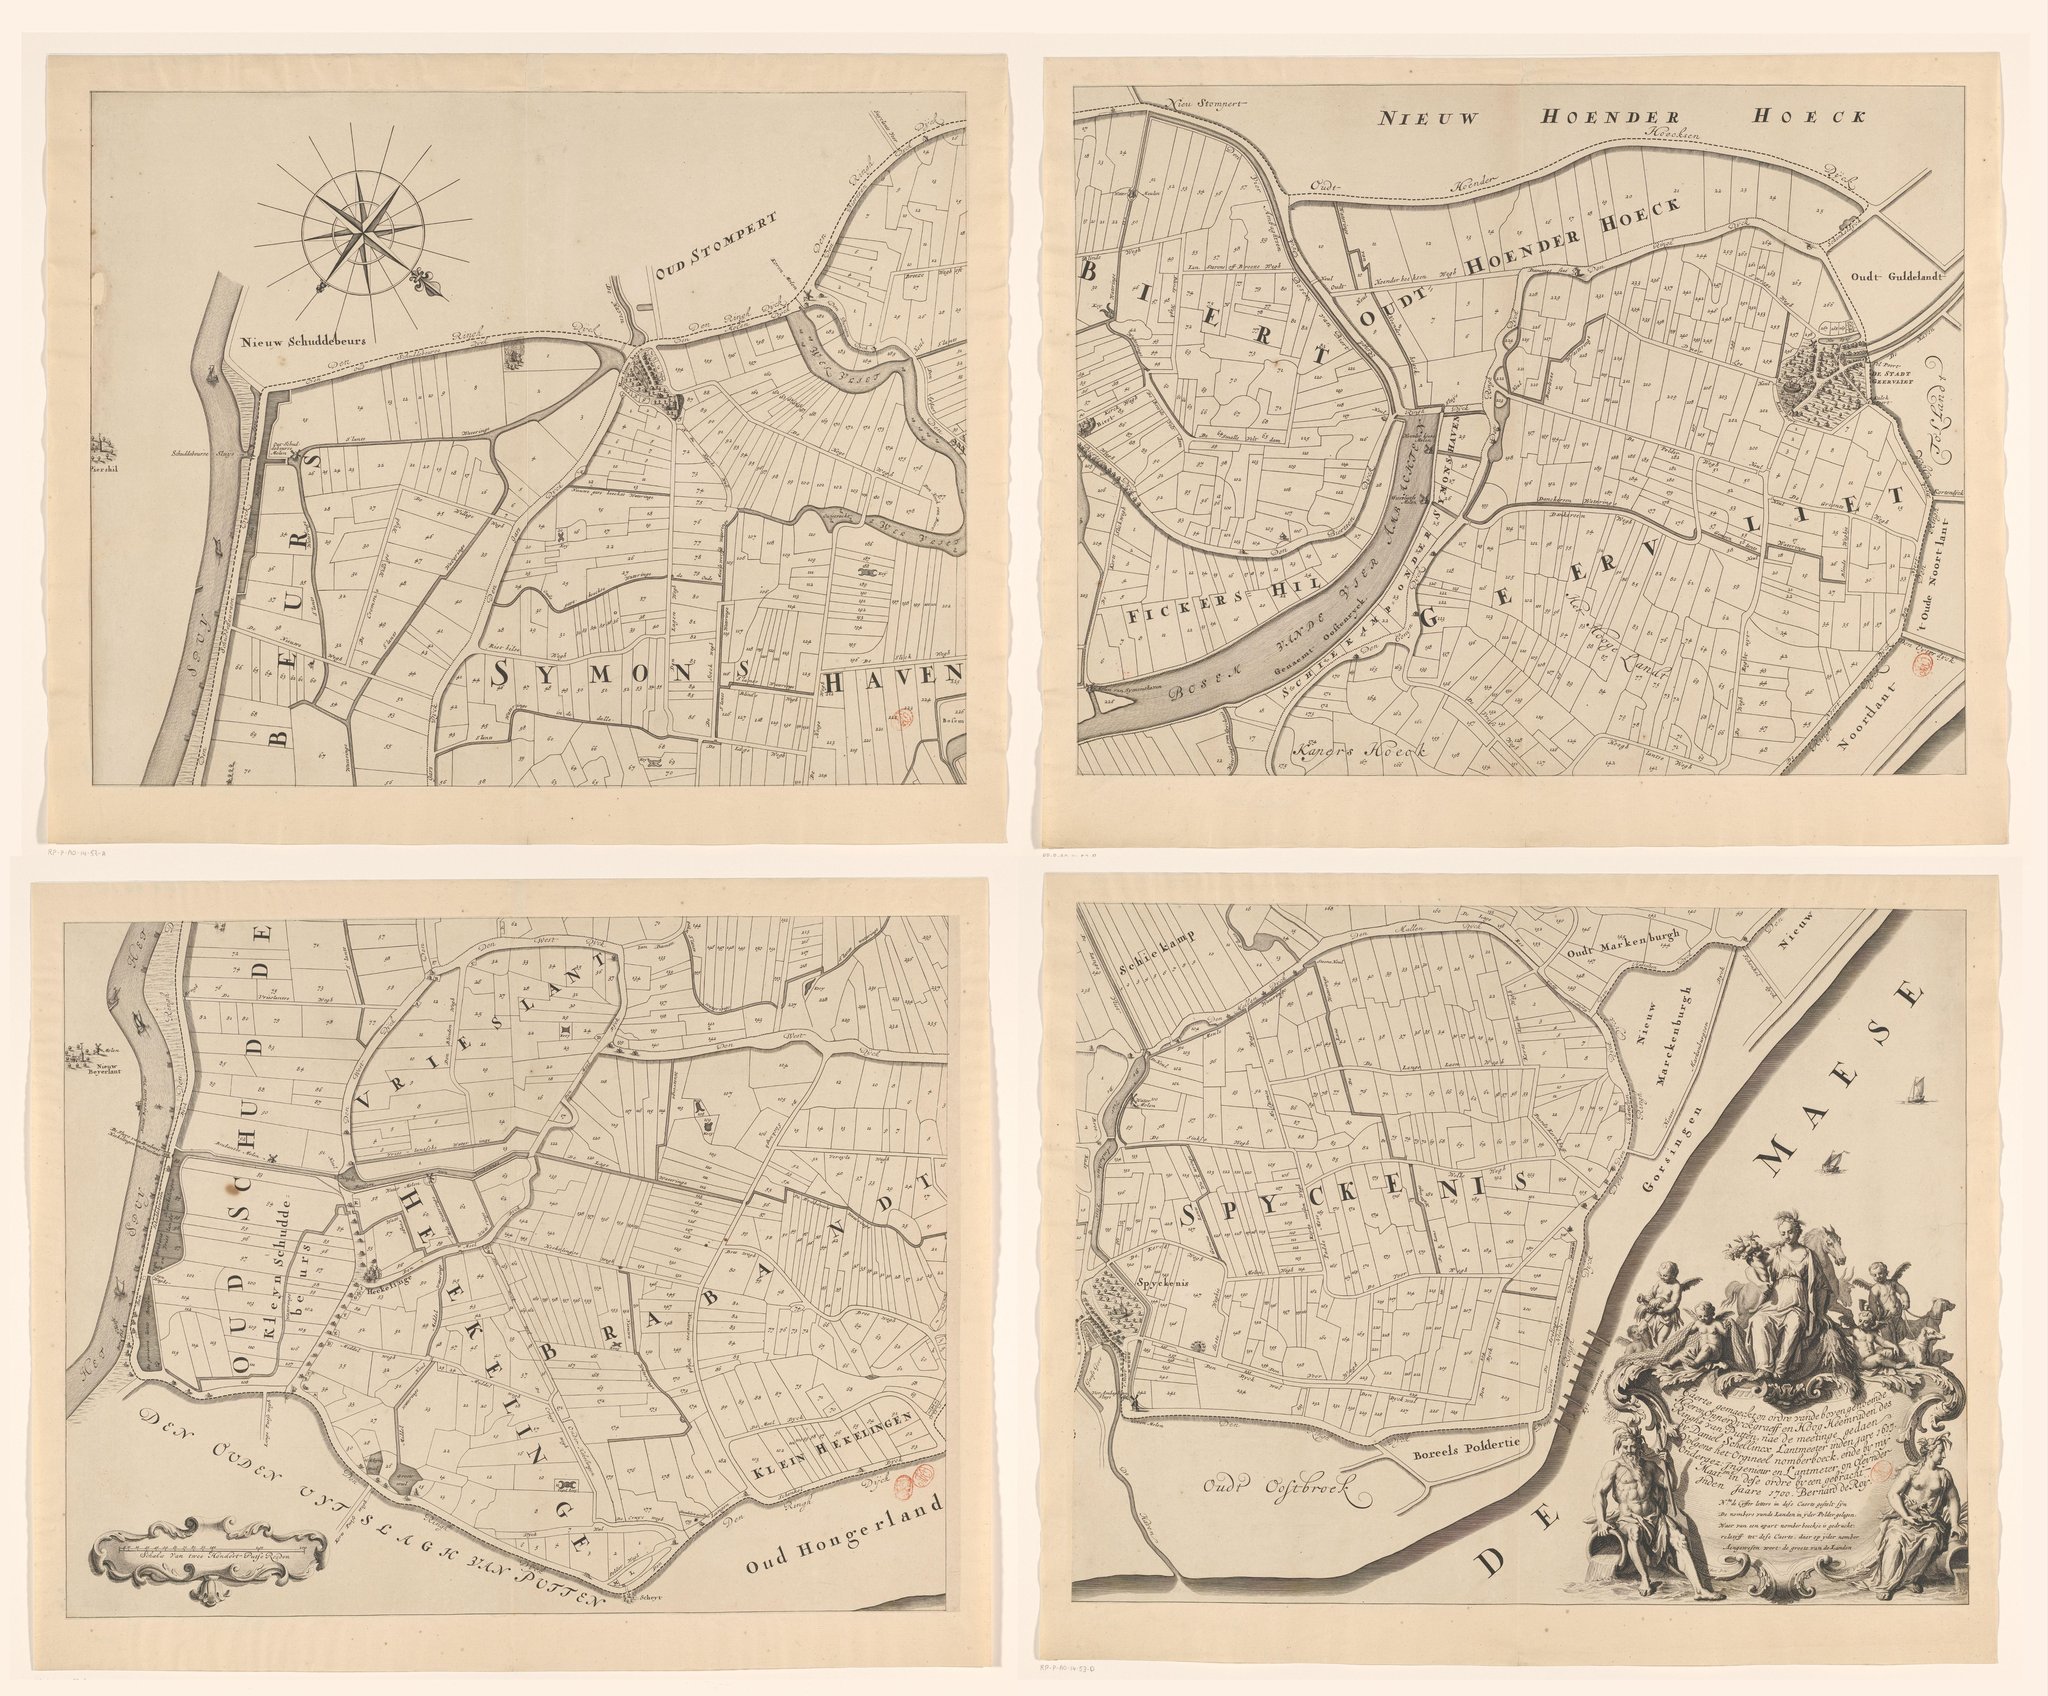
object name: print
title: Caerte gemaeckt op ordre vande bovengenoemde heeren opperdijckgraeff en hoog heemraden des Ringhs van Putten (…)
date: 1701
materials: paper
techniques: engraving, etching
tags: commercial fishery, (story of) ceres (demeter), 'cornucopia', horn of plenty, cow, maps of separate countries or regions, hunting, chase, hunting dogs, river-gods, horse, agriculture, polder, reclaimed land, cupids: 'amores', 'amoretti', 'putti'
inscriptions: collector's mark: Lugt 195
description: Dit object is omwille van een betere presentatie virtueel samengevoegd maar bestaat fysiek uit losse onderdelen. Voor zover bekend is deze kaart drie keer gedrukt; in 1701, 1738 en 1774. Deze kaart is de eerste druk. Waarschijnlijk verscheen de eerste druk (1701) zonder wapens van de opperdijkgraaf, secretaris en hoogheemraden. Voor de tweede druk (1738) werden de vier platen van de kaart bijgewerkt waardoor van elke plaat een tweede staat ontstond. Ook werd langs de bovenkant een wapenrand (gedrukt van één plaat) en langs de zijkanten een sierrand (gedrukt van twee platen) toegevoegd. Het bestuur bestond destijds uit opperdijkgraaf Gualterus de Raet, secretaris Nicolaas Hooreman en hoogheemraden Dirck Lieve, Cornelis Taal, Adriaen Roosmael, Pieter van der Mersch en Johannes Assuerus Roosendael. Zie RP-P-AO-14-53A voor een exemplaar van de tweede druk/staat (zonder sierrand). Voor de derde druk (1774) werd in ieder geval de plaat rechtsonder bijgewerkt. Verder onderzoek is nodig om vast te stellen of de drie andere platen van de kaart ook werden bijgewerkt. Het bestuur bestond destijds uit opperdijkgraaf Dirk Bouwens, secretaris Carel Willem Hogerwaard en hoogheemraden Joh. van der Zaag, Hendrik Hoogendyck, Jan Jacob Villerius, Dammis Hoogendyck en Paulus Gevers.